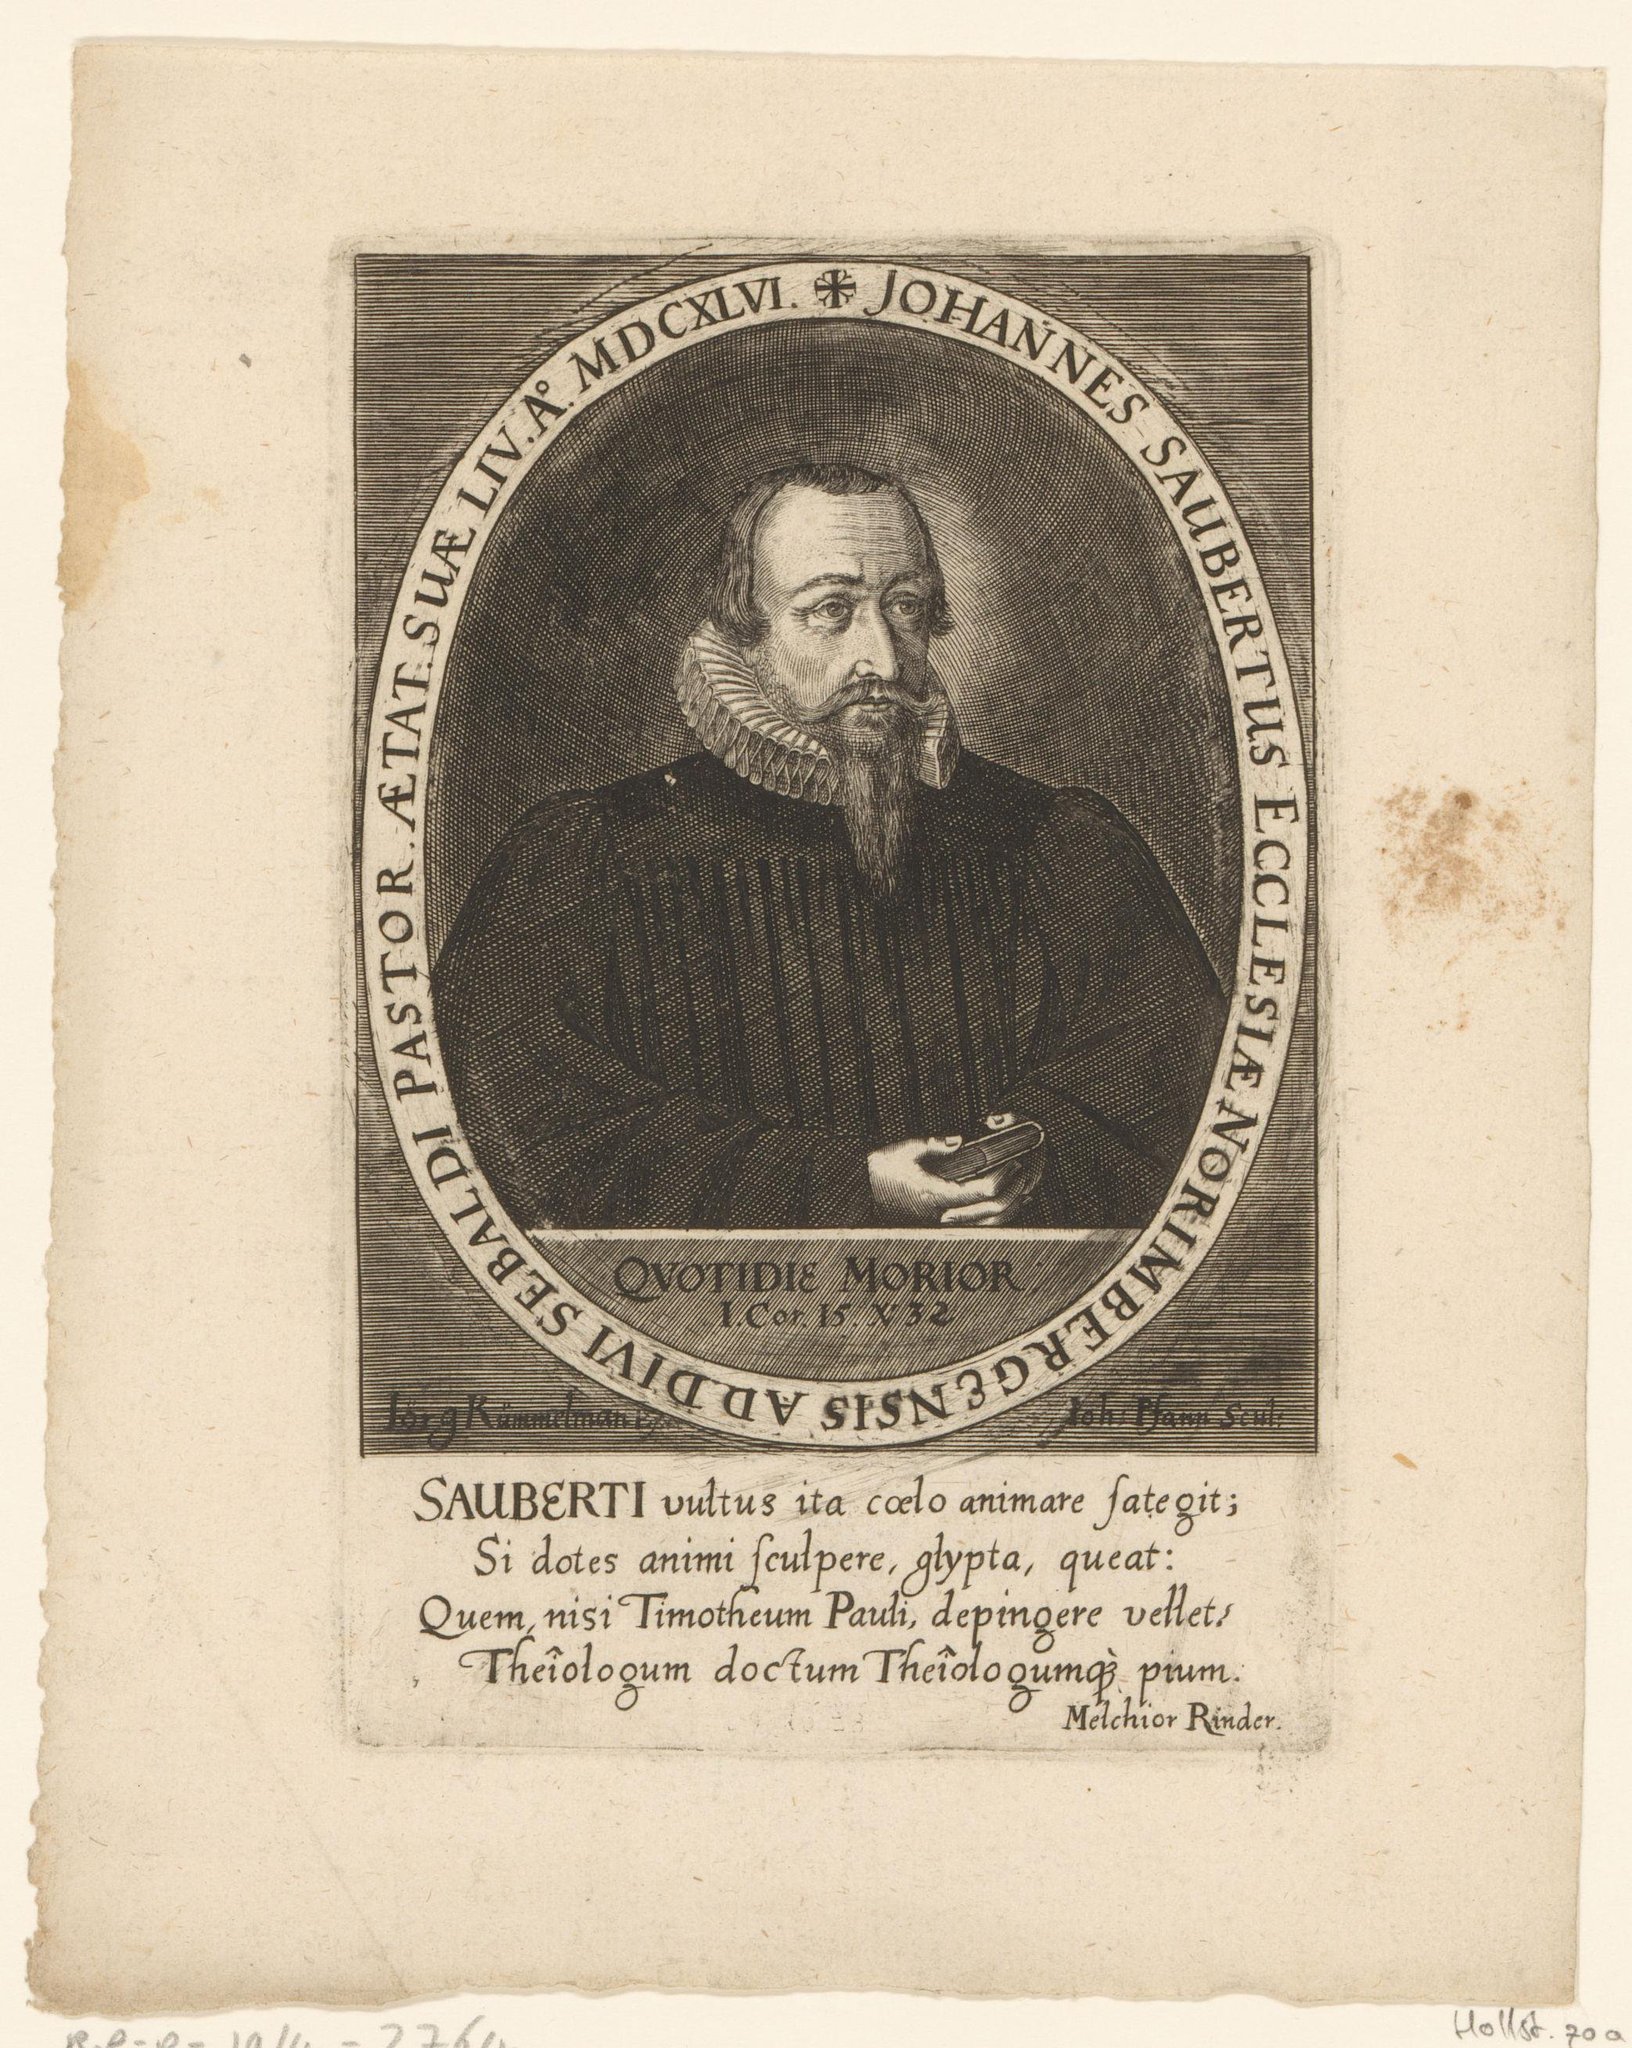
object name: print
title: Portret van Johann Saubert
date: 1646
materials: paper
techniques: engraving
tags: johann saubert (i), historical persons, book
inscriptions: collector's mark: Lugt 2228